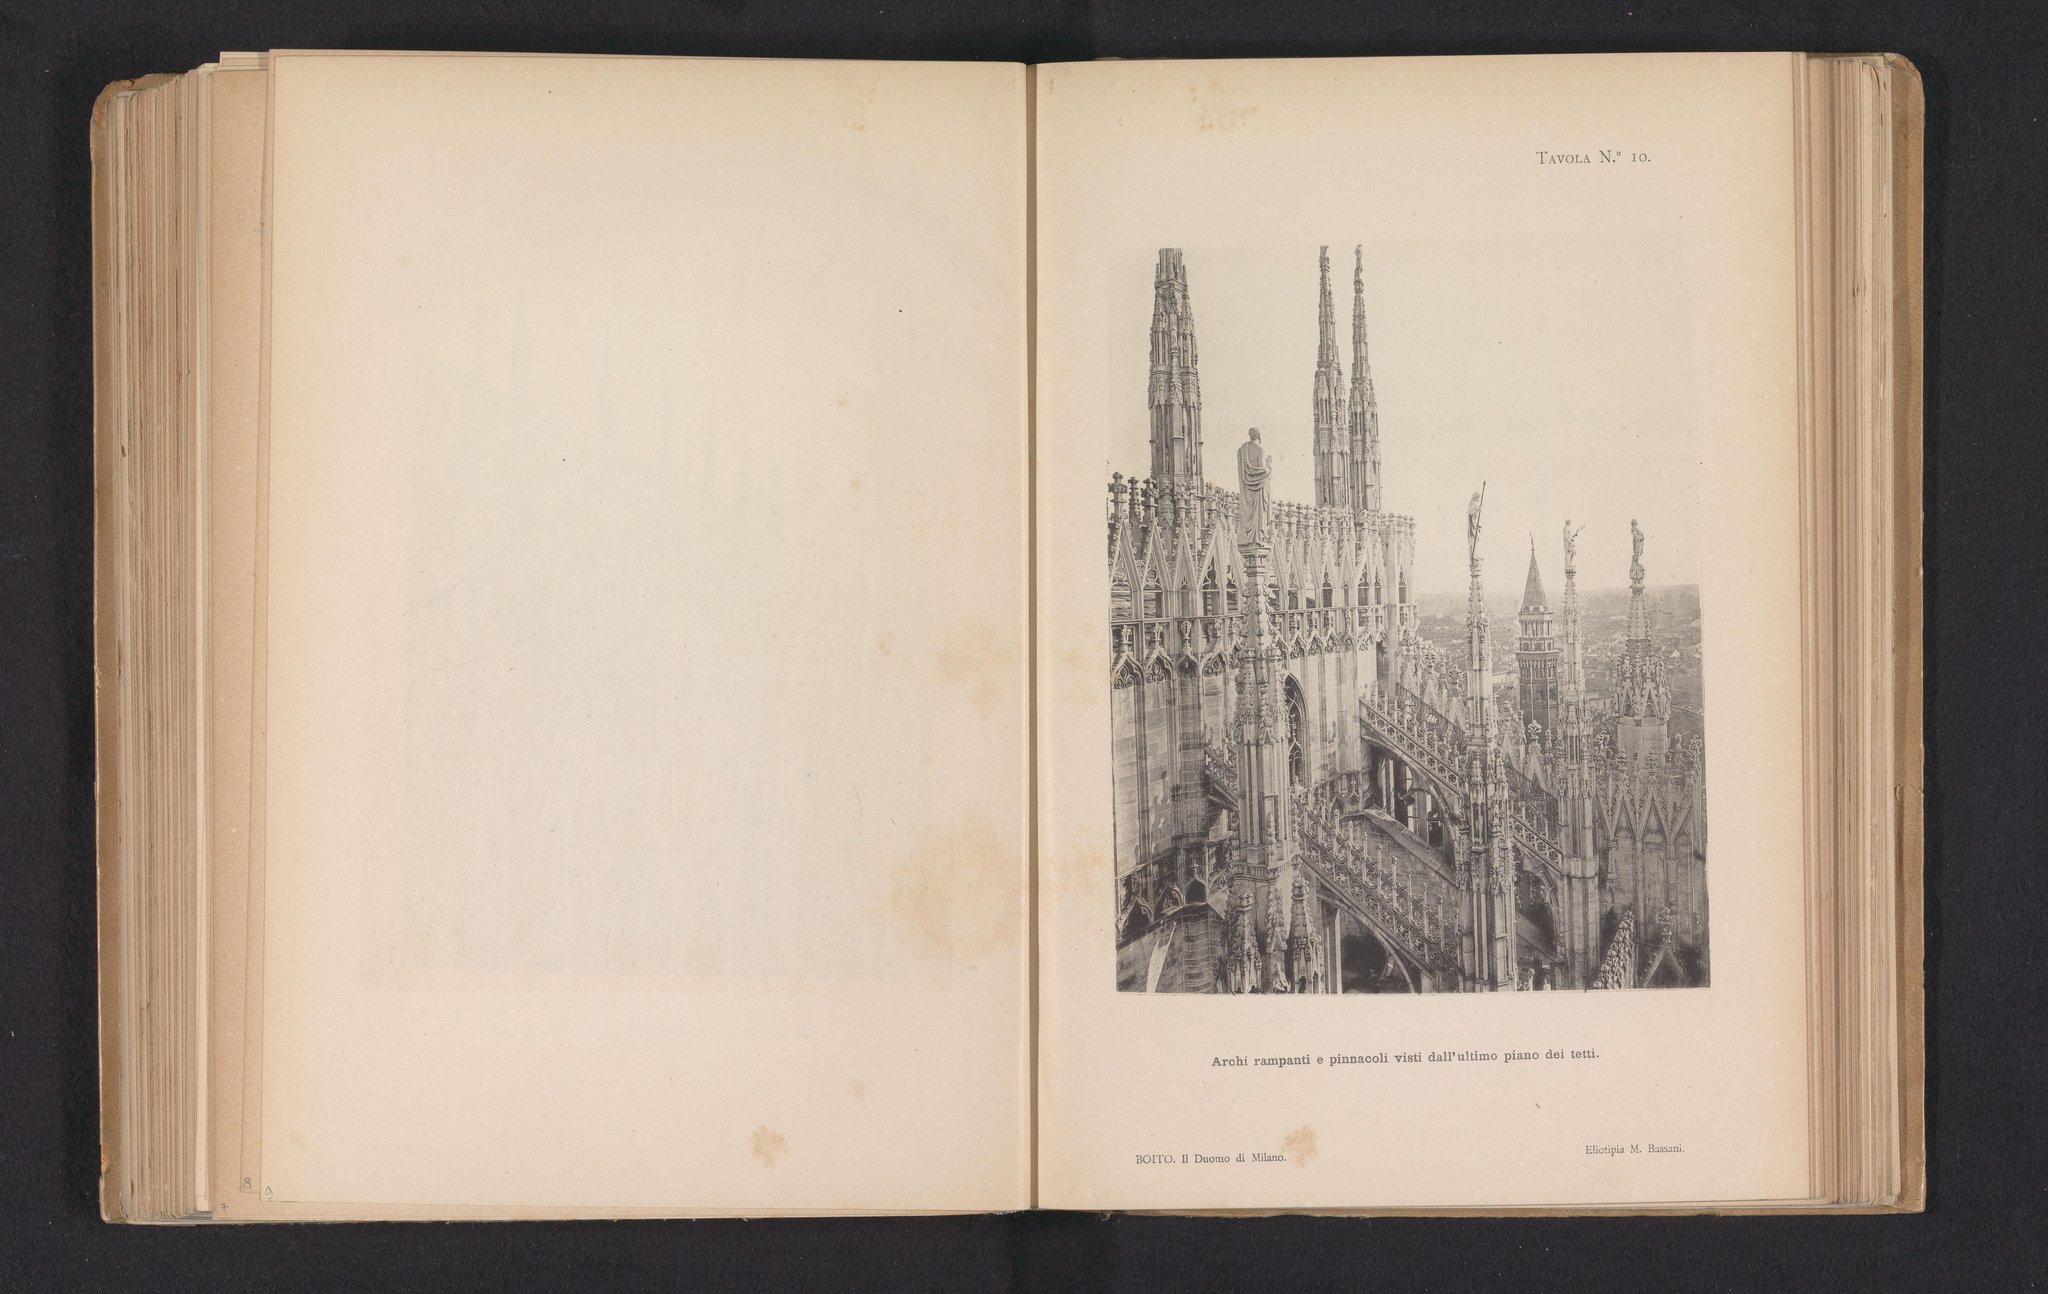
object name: page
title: Gezicht op luchtbogen, steunberen en het dak van de Dom van Milaan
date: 1879-1889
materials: paper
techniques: photograph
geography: milan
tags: roof (of house or building), church (exterior), piece of sculpture, reproduction of a piece of sculpture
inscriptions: number: ‘Tavola No. 10.’